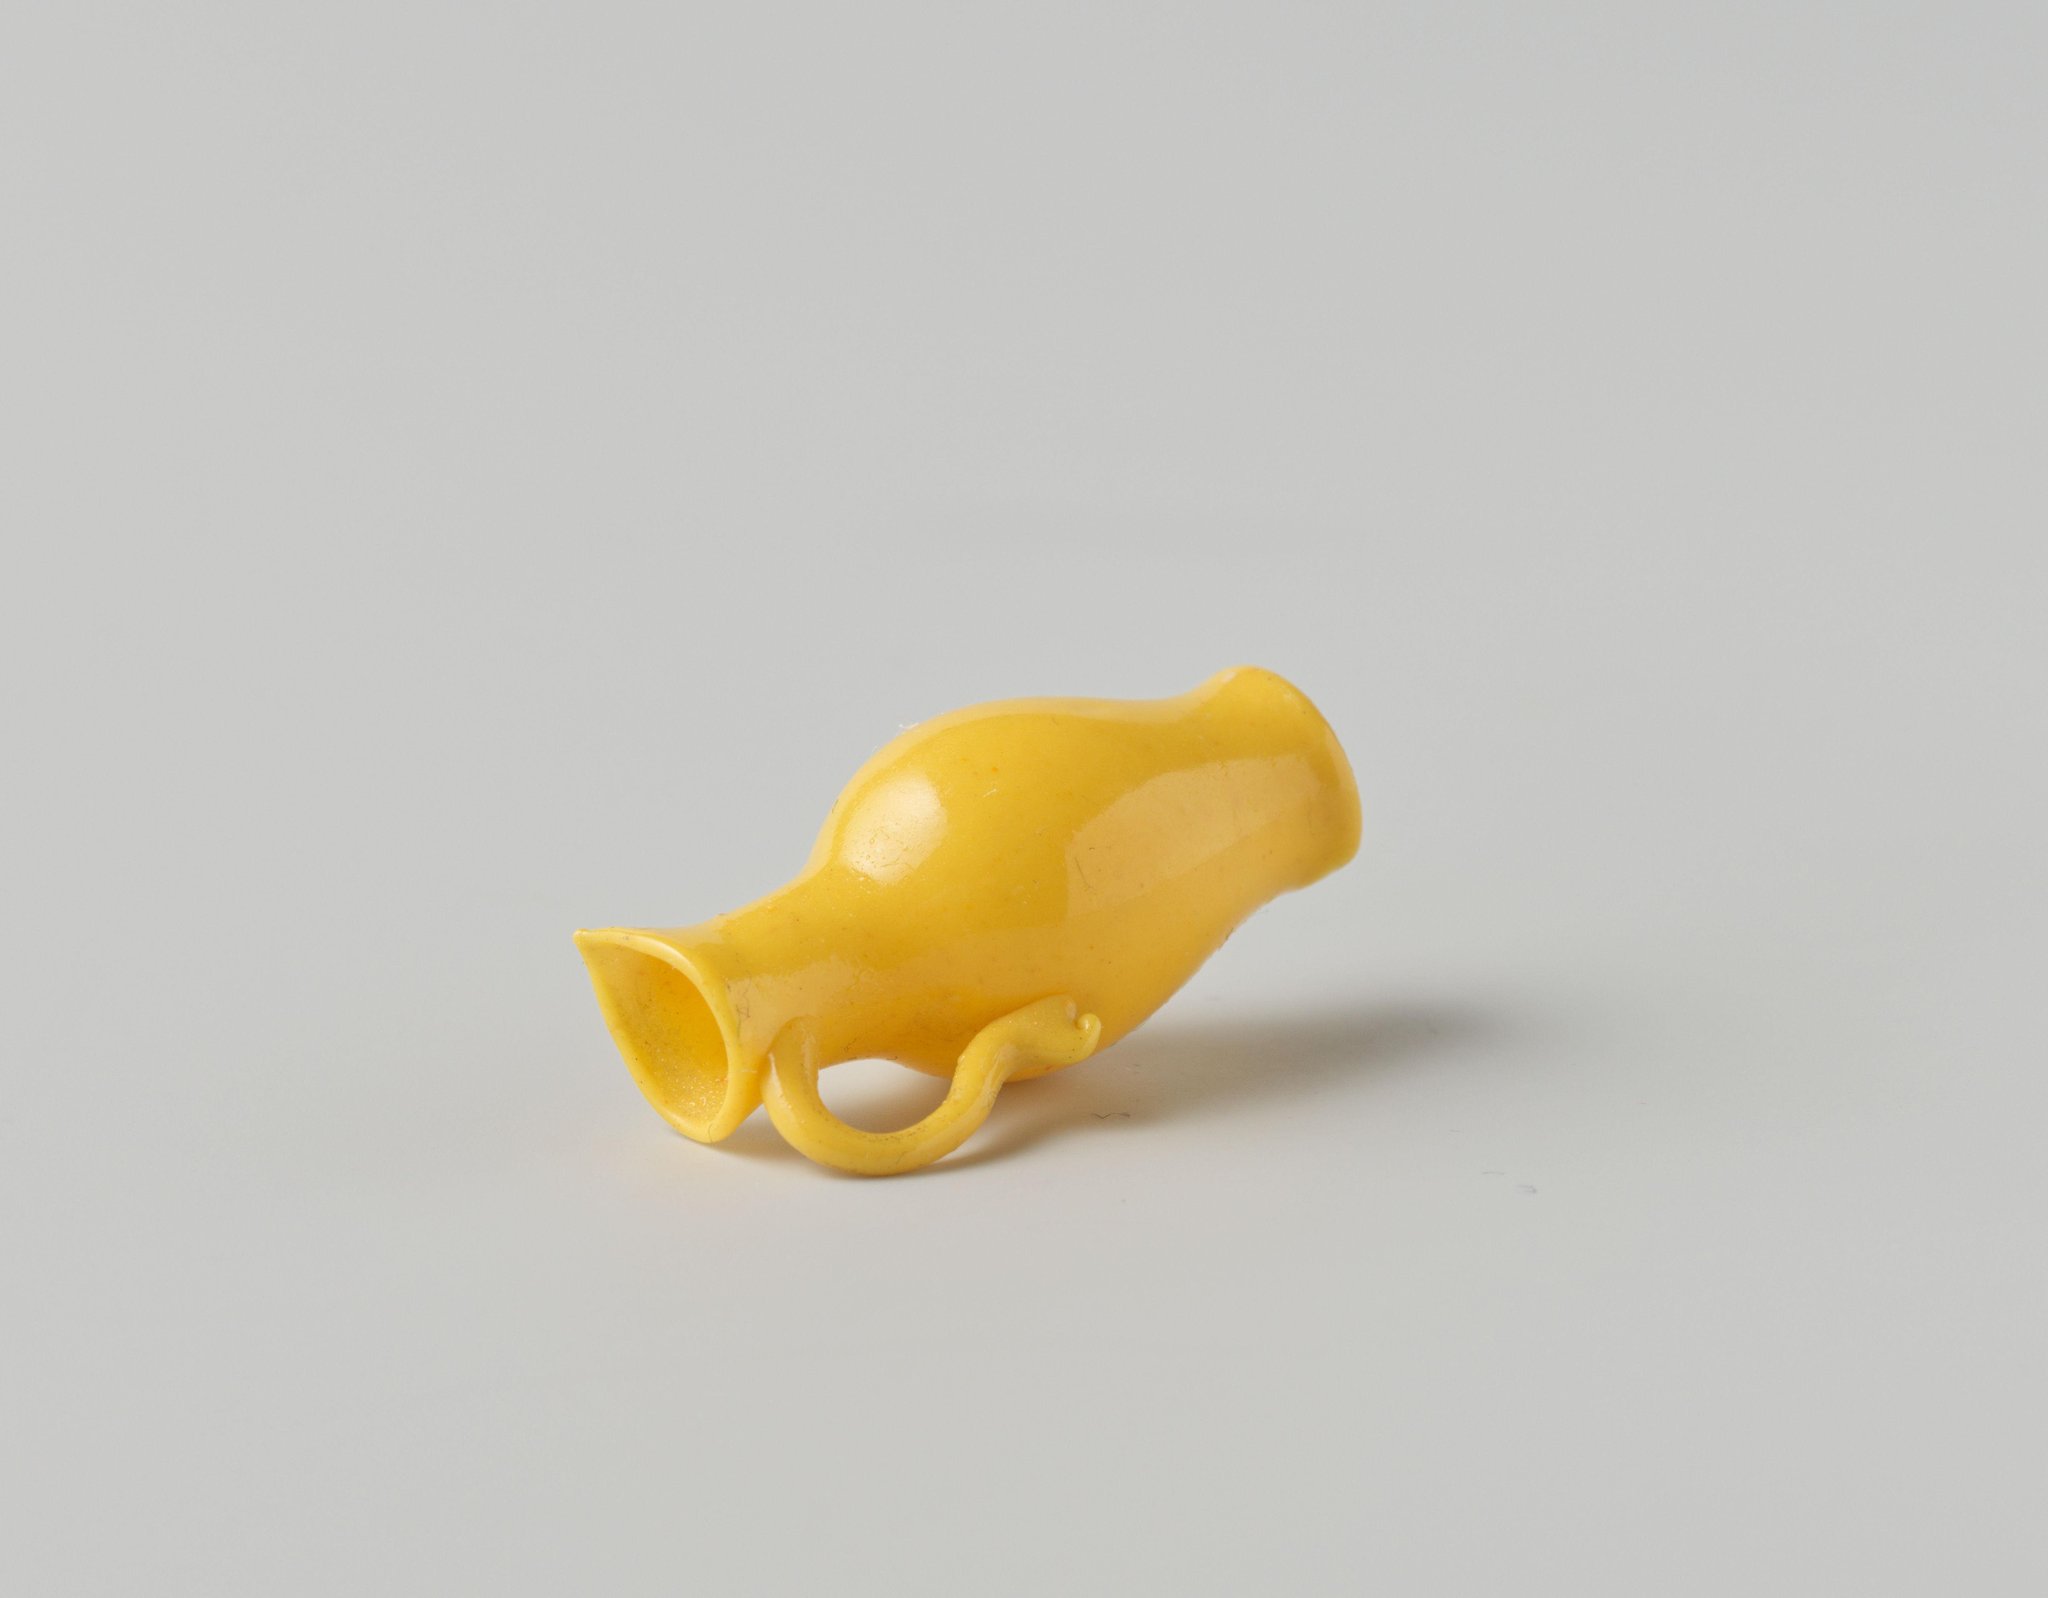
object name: ewer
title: Kan van opaak geel glas (waarschijnlijk imitatie geel aardwerk); bol en slank model met schenklip, aangezet oor en naar binnen gestoken bodem.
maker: Anonymous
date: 1675-1710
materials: glass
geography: amsterdam